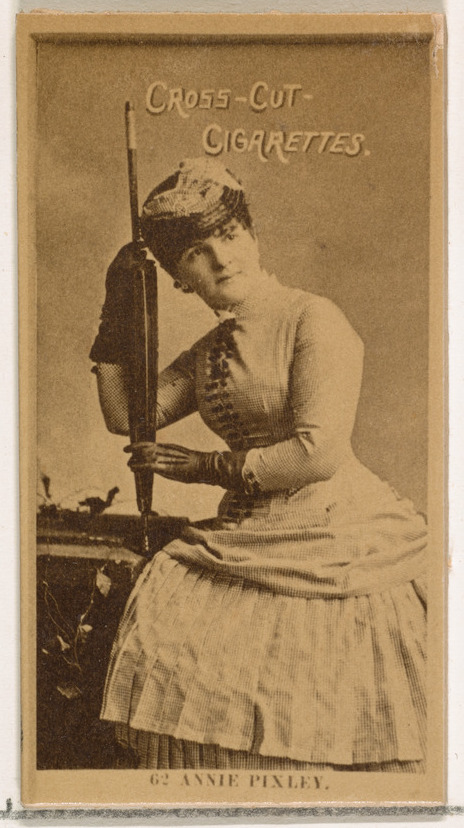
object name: print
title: Card Number 62, Annie Pixley, from the Actors and Actresses series (N145-2) issued by Duke Sons & Co. to promote Cross Cut Cigarettes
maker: w. duke, sons & co.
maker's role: publisher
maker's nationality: american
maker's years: 1870-1920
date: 1880-1889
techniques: albumen silver print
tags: women,actresses